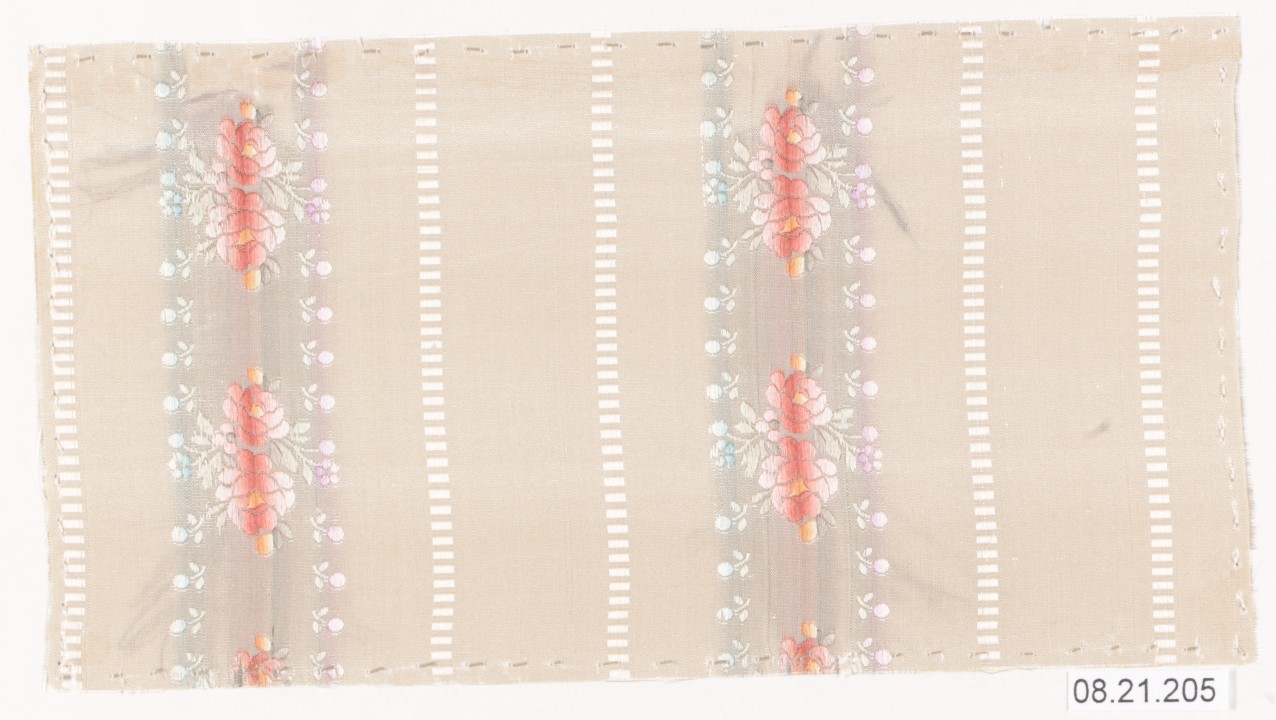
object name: textile sample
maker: Anonymous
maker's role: designer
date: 1900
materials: silk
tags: flowers